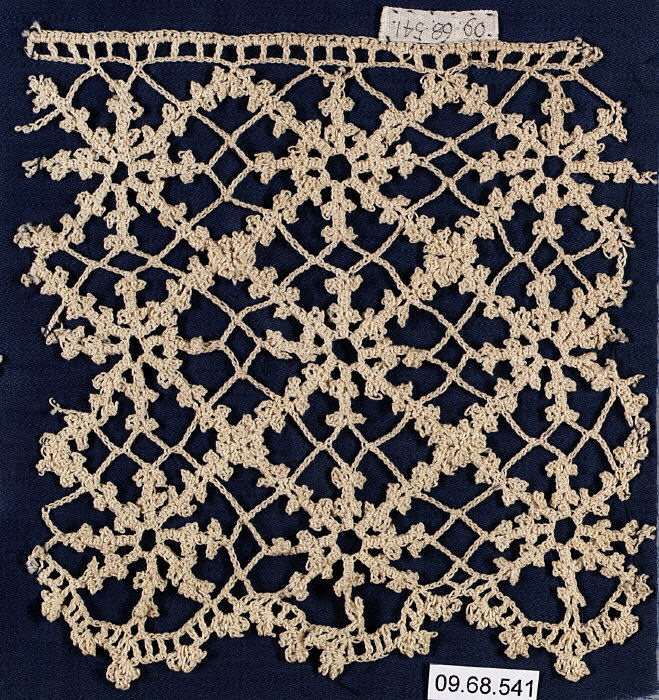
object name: piece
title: Piece (one of two)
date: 1801-1900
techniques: crochet